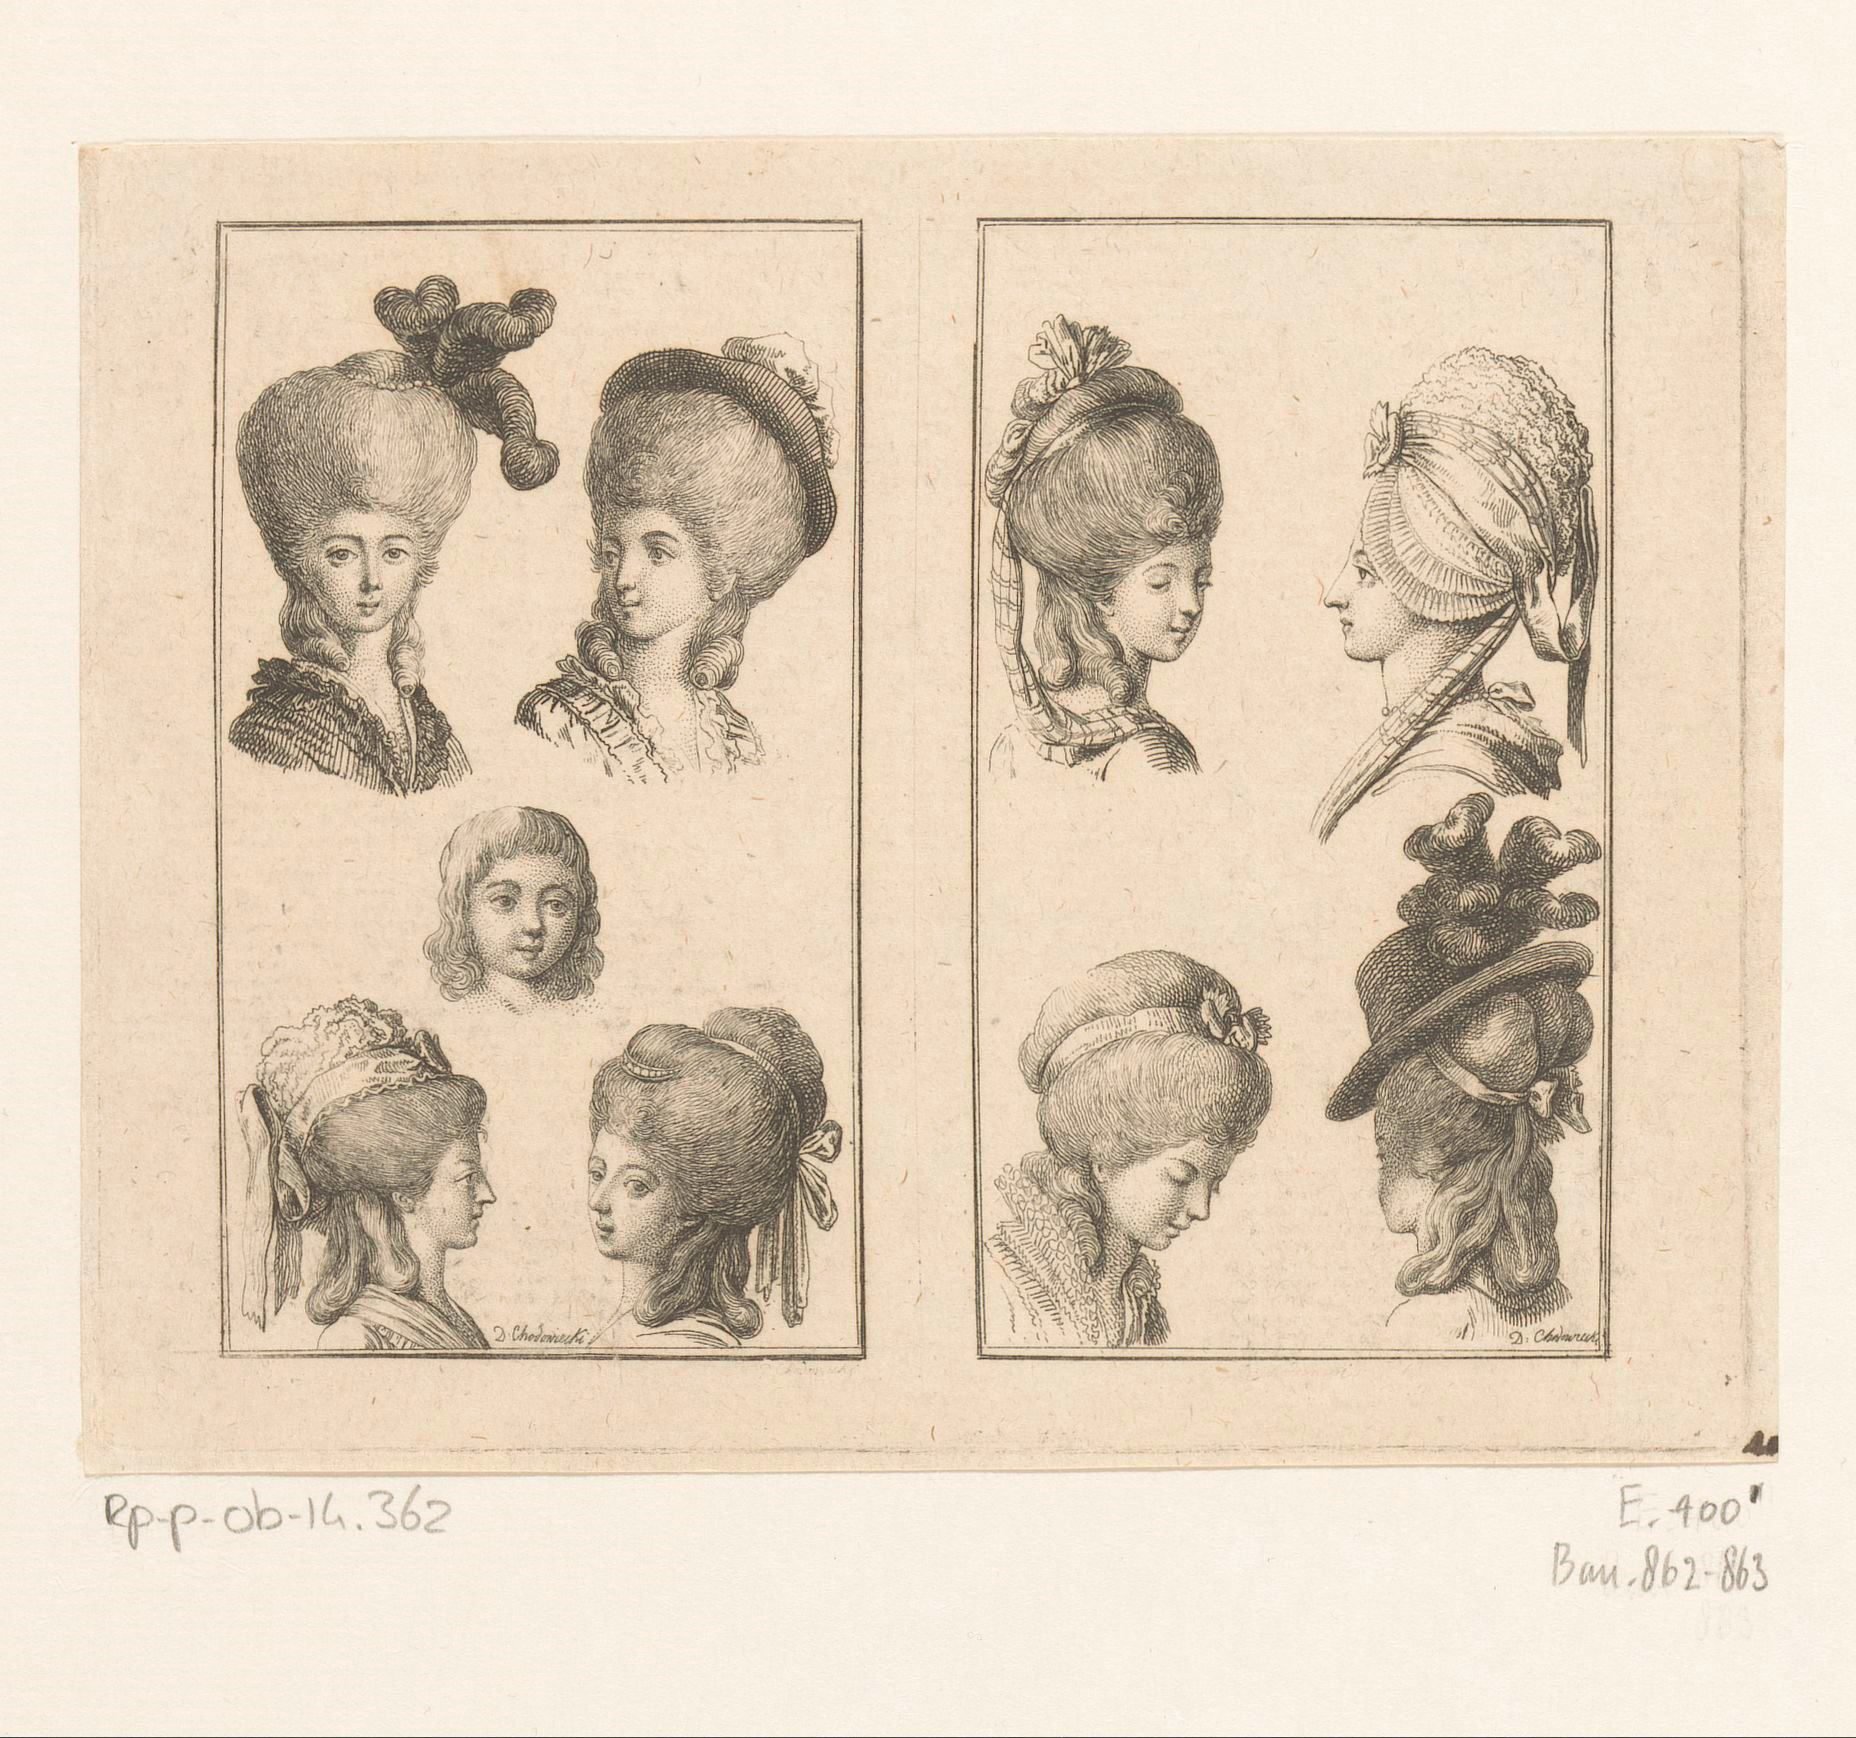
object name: print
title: Twee voorstellingen met kapsels en hoofddeksels voor dames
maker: daniel nikolaus chodowiecki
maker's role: draughtsman, print maker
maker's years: 1726-1801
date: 1781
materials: paper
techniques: etching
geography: berlin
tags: head-gear, styles of hairdress - aa - ~ women, fashion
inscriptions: collector's mark: Lugt 2228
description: Latere staat gebruikt voor: Almanac de Gotha contenant diverses connoissances curieuses et utiles pour l'année MDCCLXXXII. Gotha: C. W. Ettinger, 1782.